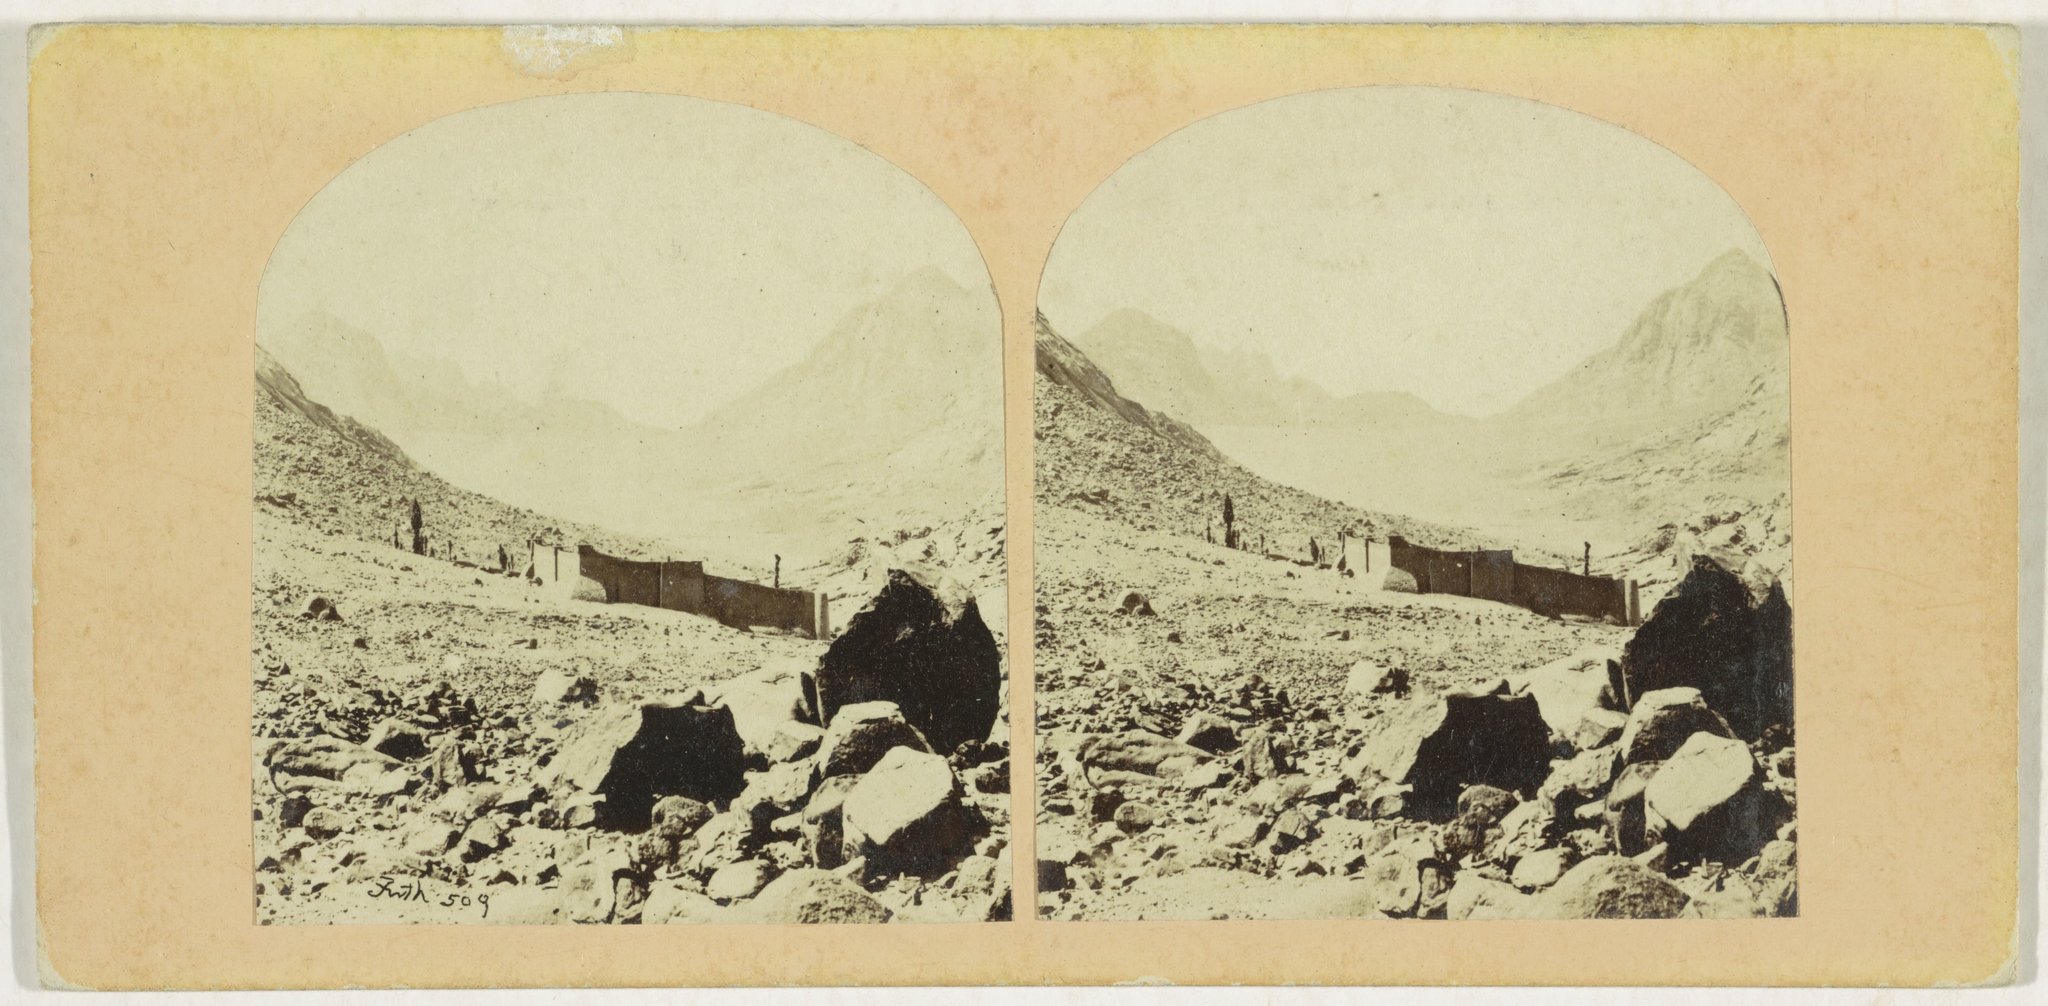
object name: stereograph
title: Views in the Peninsula of Sinai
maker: francis frith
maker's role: publisher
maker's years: 1822-1898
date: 1859-1861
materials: cardboard, paper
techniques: albumen print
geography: st. catherine's monastery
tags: abbey, monastery, convent ~ roman catholic church, desert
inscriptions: number: ‘506.’, inscription: ‘[Deposé.’, inscription: ‘Entered at Stationers' Hall.]’, inscription: ‘THESE views are taken from the path on the ascent of Jebel Mousa, and (...)’, number: ‘509’, inscription: ‘Le Convent du Sinaï en la plaine [...] de En-Raheh.’